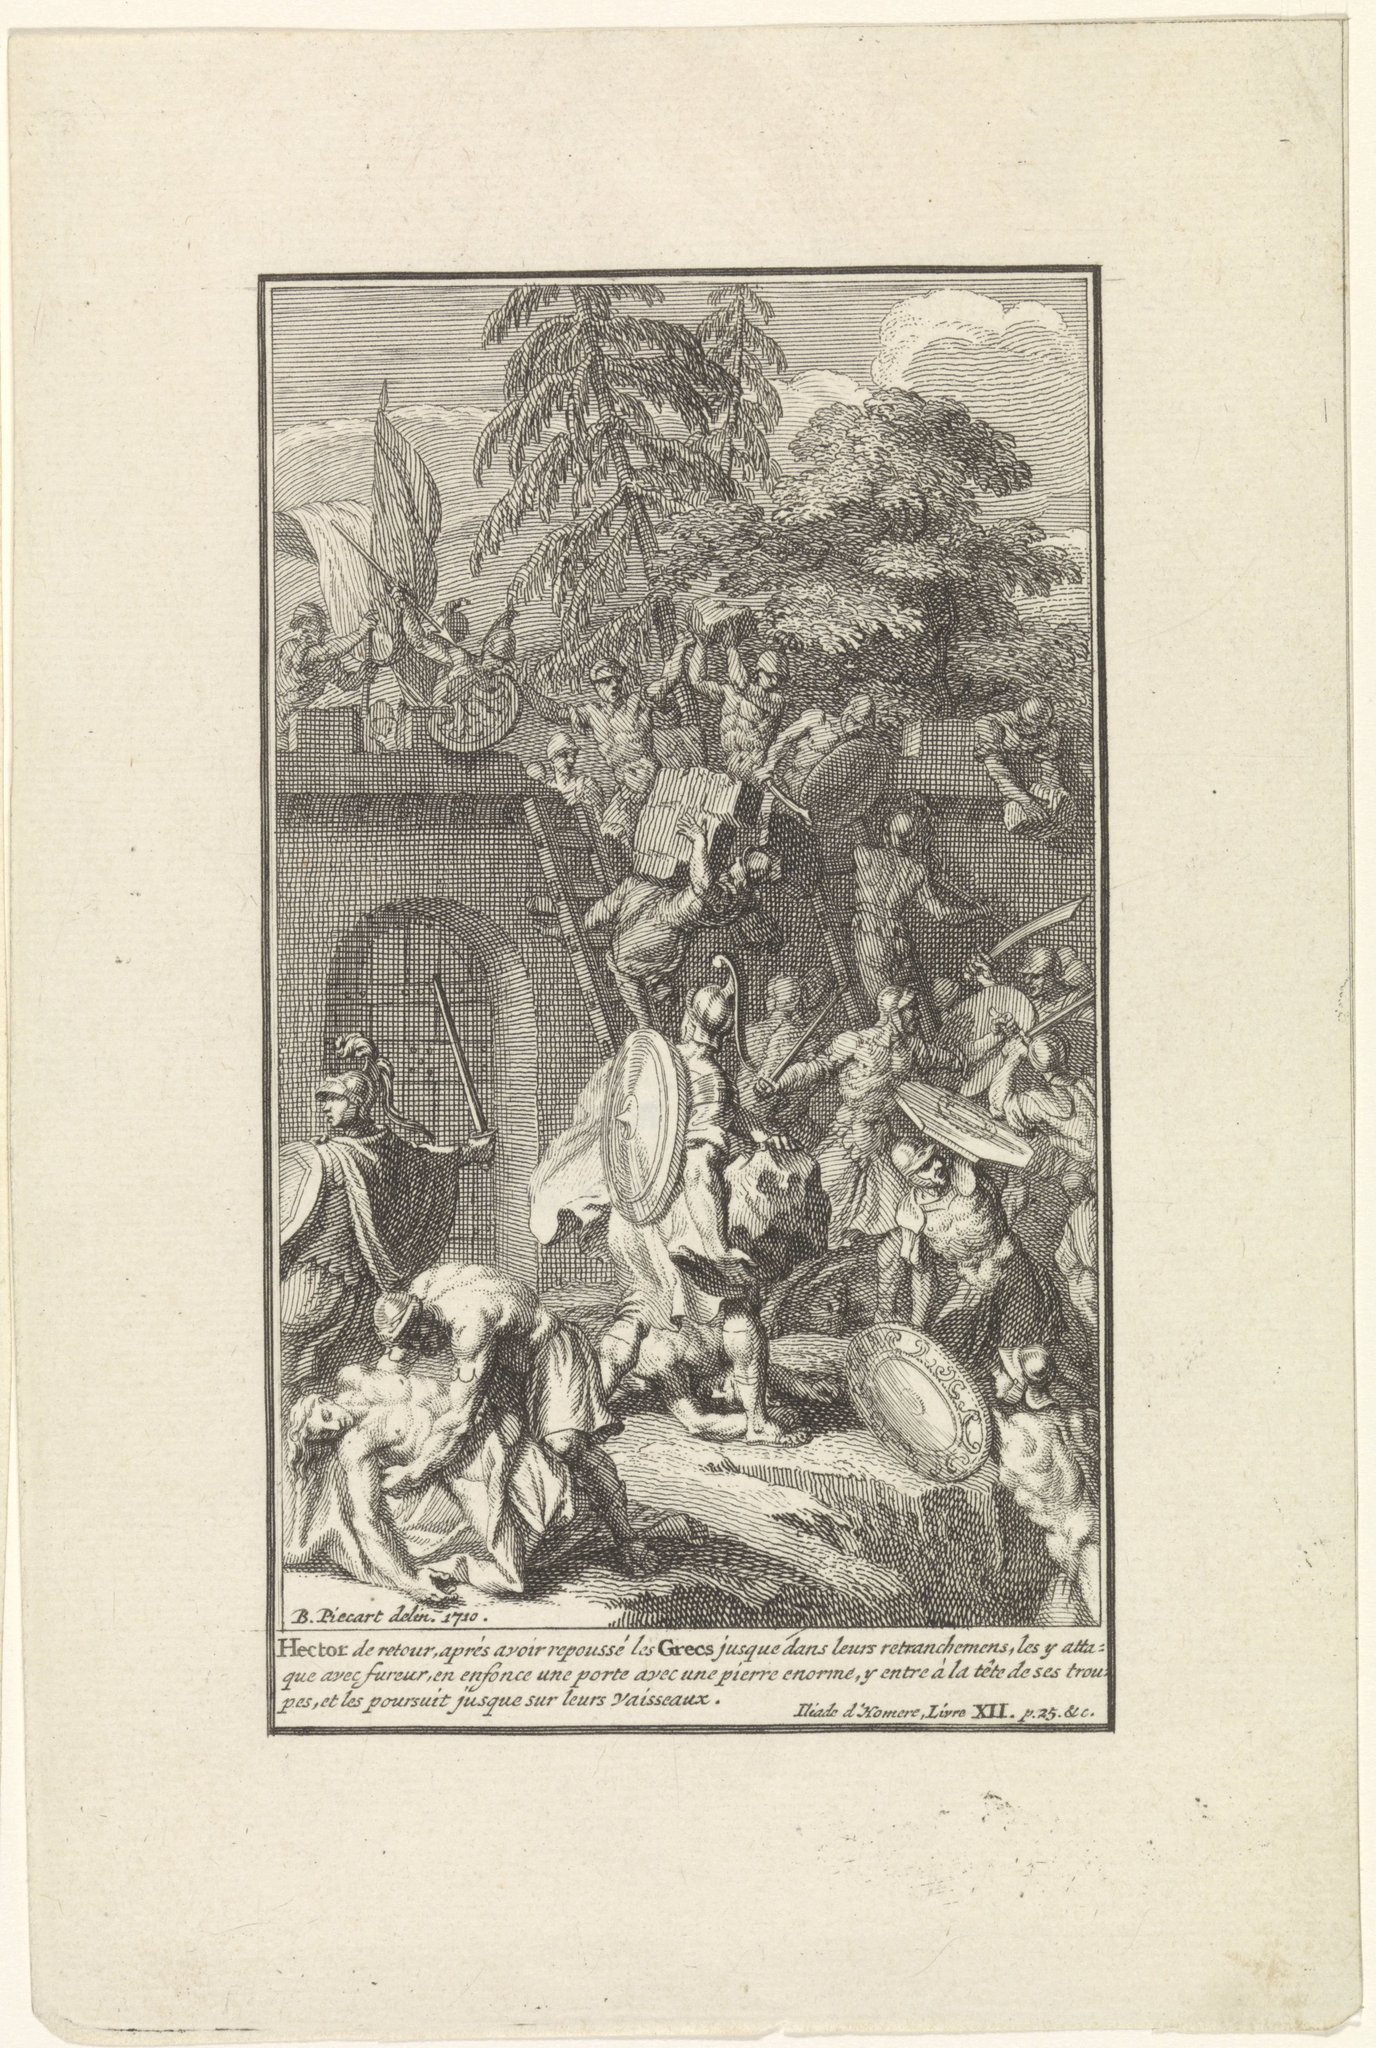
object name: book illustration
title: Trojanen bestormen het Griekse kamp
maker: bernard picart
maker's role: draughtsman, print maker, publisher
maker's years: 1673-1733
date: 1710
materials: paper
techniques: engraving, etching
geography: amsterdam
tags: the battle turns against the greeks (iliad xi-xv)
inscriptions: collector's mark: Lugt 2228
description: De Trojanen dringen onder leiding van Hector door de muur rond het Griekse legerkamp. In de marge een onderschrift in het Frans.